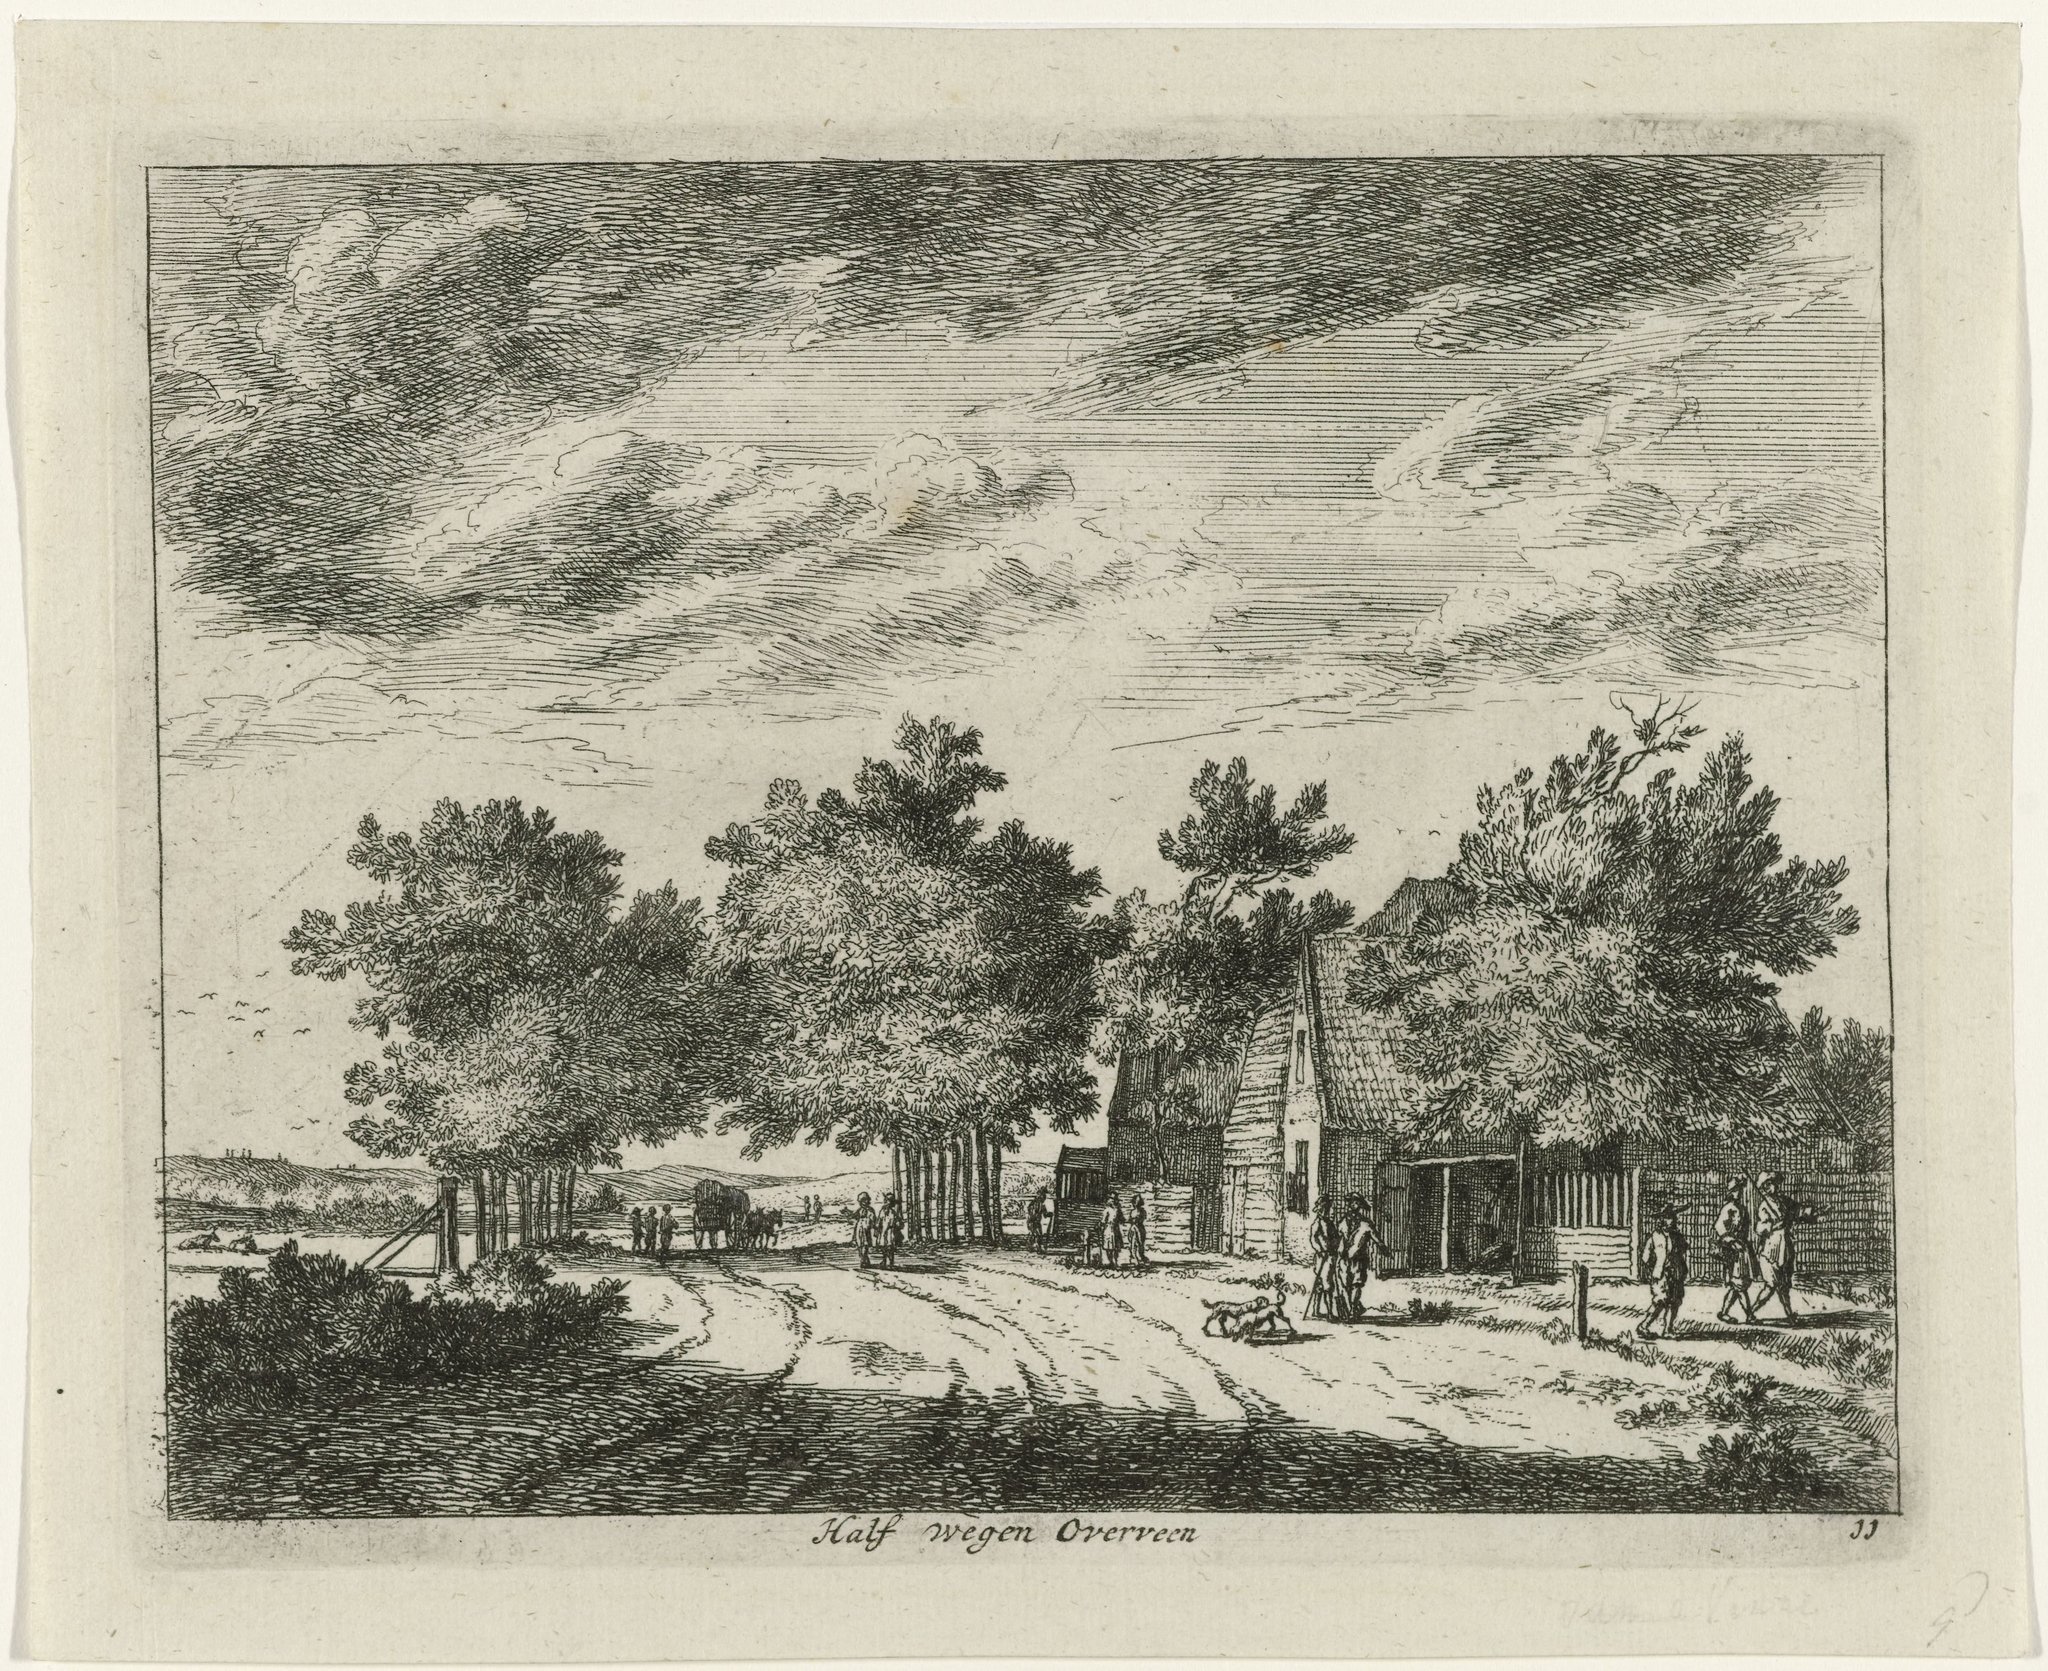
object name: print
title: Half wegen Overveen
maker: jan vincentsz. van der vinne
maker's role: draughtsman, print maker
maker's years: 1663-1721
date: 1688-1690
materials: paper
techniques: etching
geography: haarlem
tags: covered wagon, hooded wagon, landscapes (+ landscape with figures, staffage), outskirts of village (+ city(-scape) with figures, staffage), haarlem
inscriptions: collector's mark: ‘v.D’, collector's mark: Lugt 2228, collector's mark: ‘IB’, collector's mark: Lugt 2760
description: Boerderij gelegen langs een pad. Rechts vijf figuren en twee honden. Op de achtergrond een huifkar. Rechtsonder genummerd: 11.